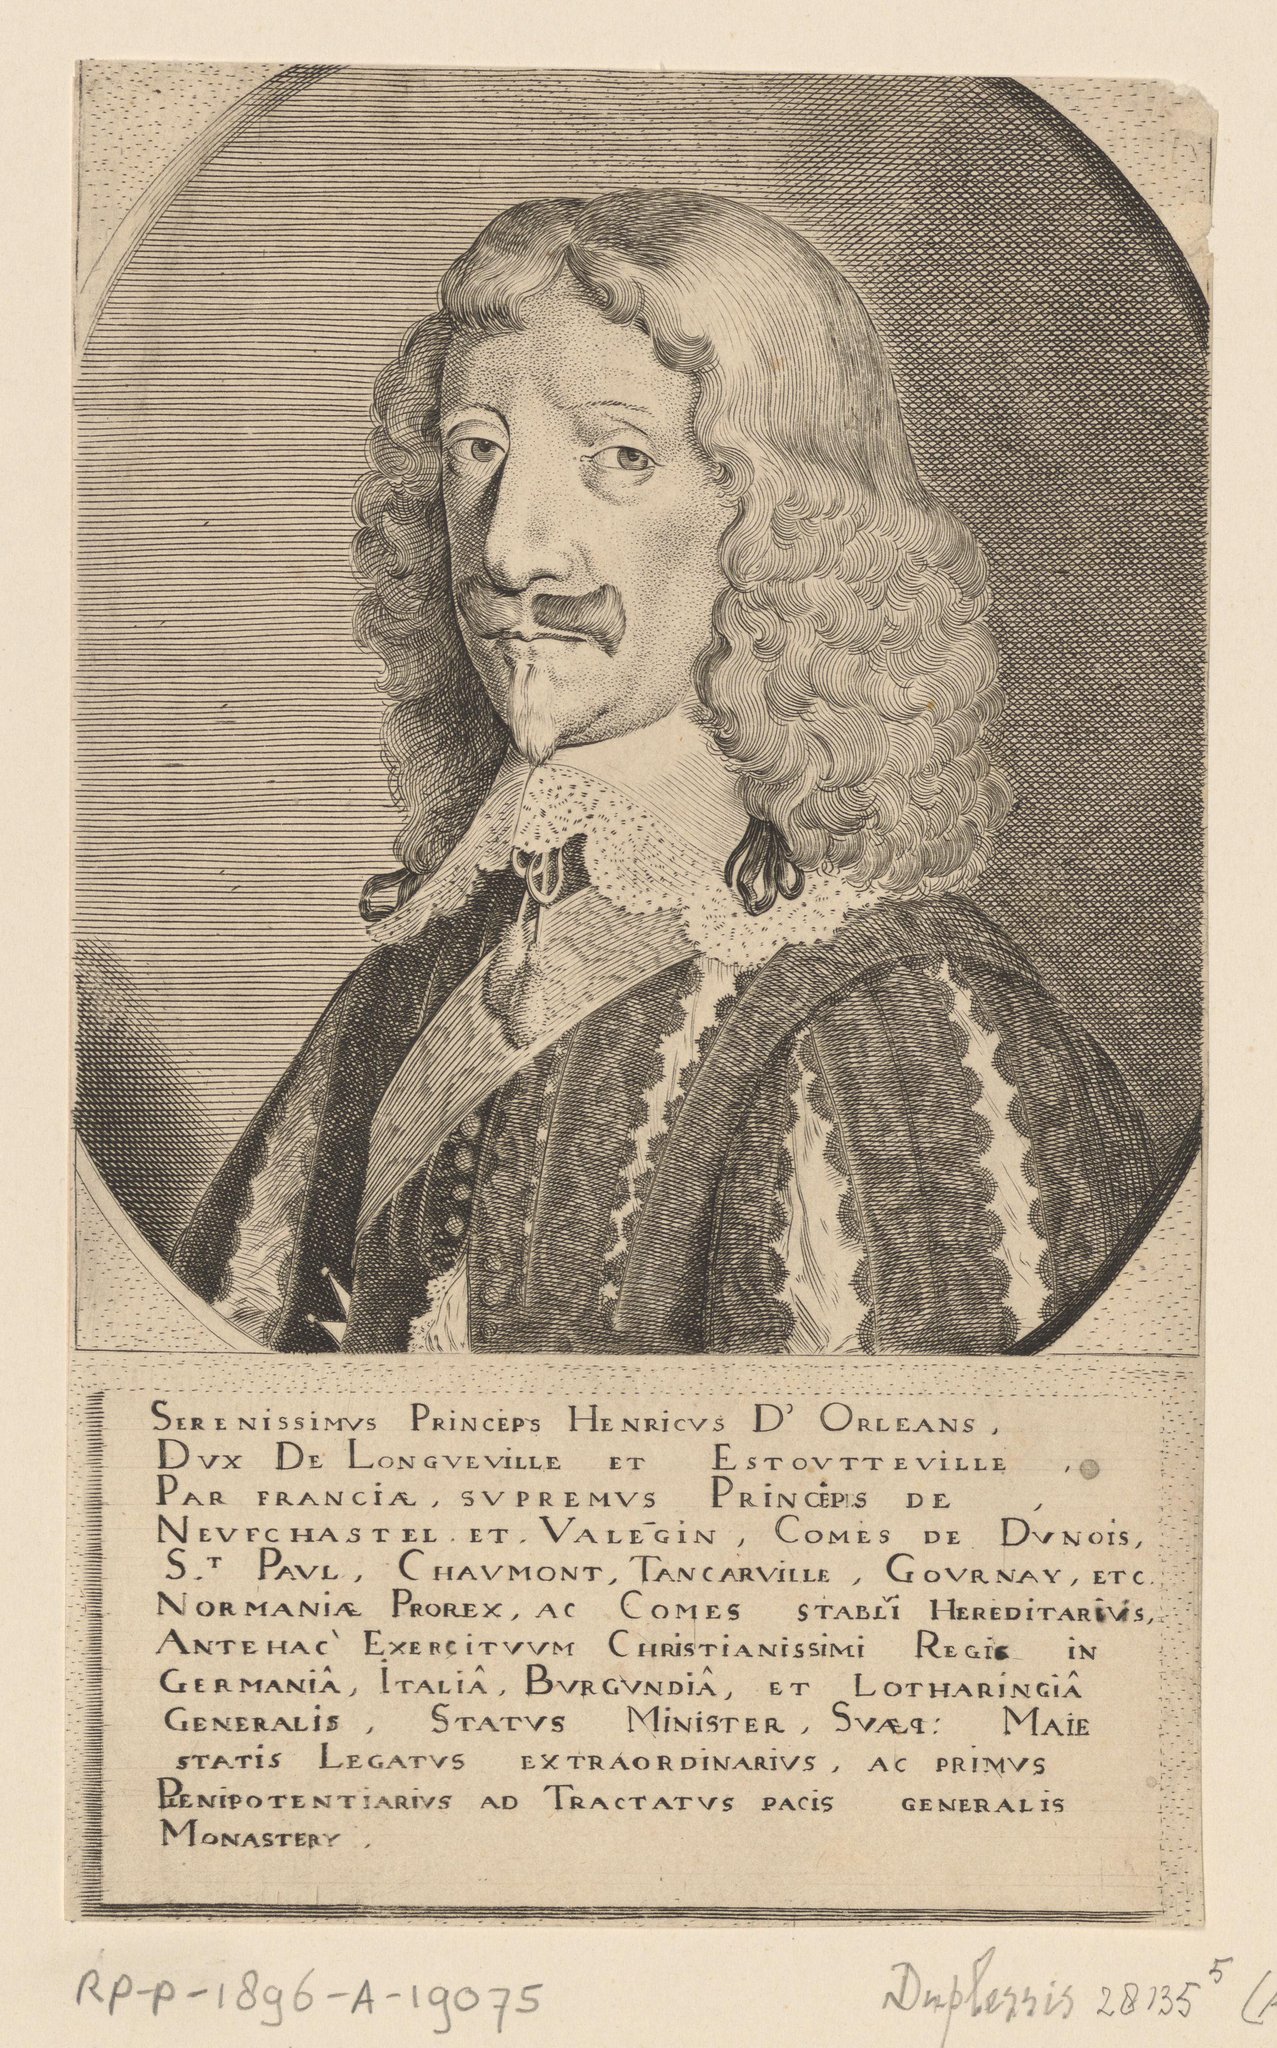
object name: print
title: Portret van Henri II d'Orléans, hertog van Longueville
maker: pieter holsteyn (ii)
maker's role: draughtsman, print maker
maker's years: 1614-1673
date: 1630-1663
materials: paper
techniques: engraving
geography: northern netherlands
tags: historical persons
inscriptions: collector's mark: Lugt 2228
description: Twaalfregelig onderschrift in het Nederlands.